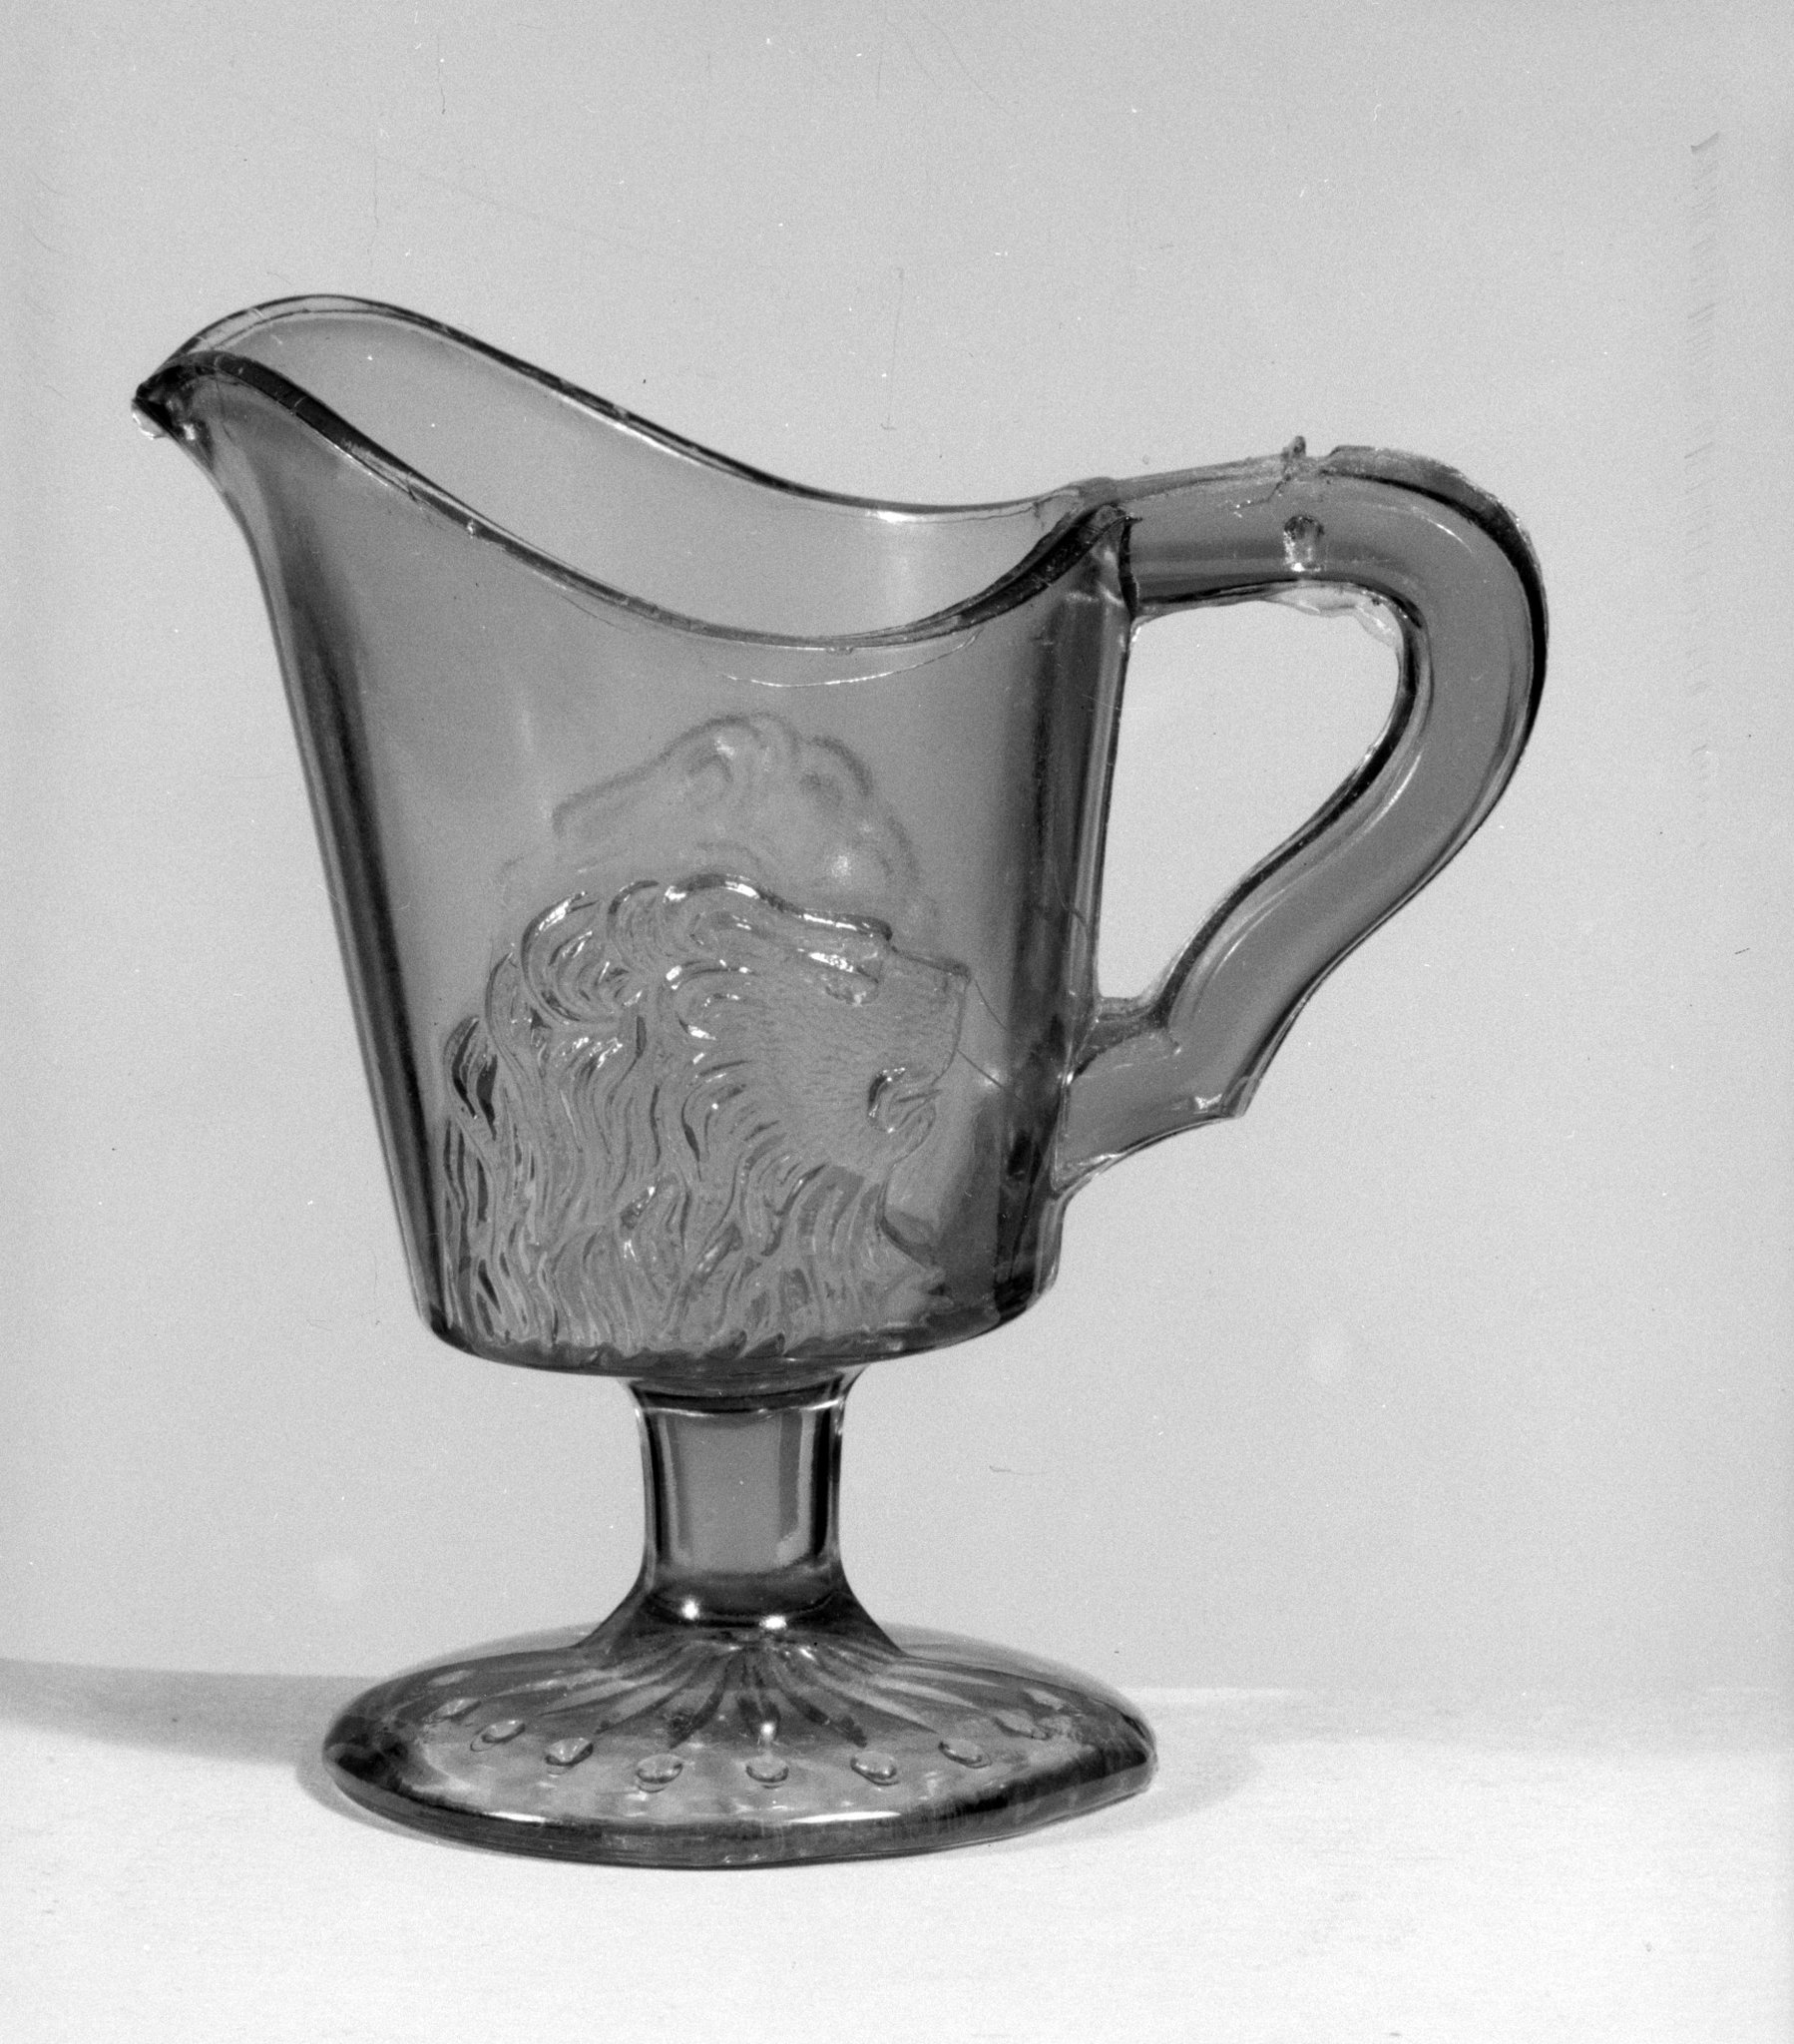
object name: cream pot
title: Creamer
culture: american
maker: james gillinder and sons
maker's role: maker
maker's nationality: american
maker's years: 1861-1930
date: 1870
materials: glass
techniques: pressed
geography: united states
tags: lions